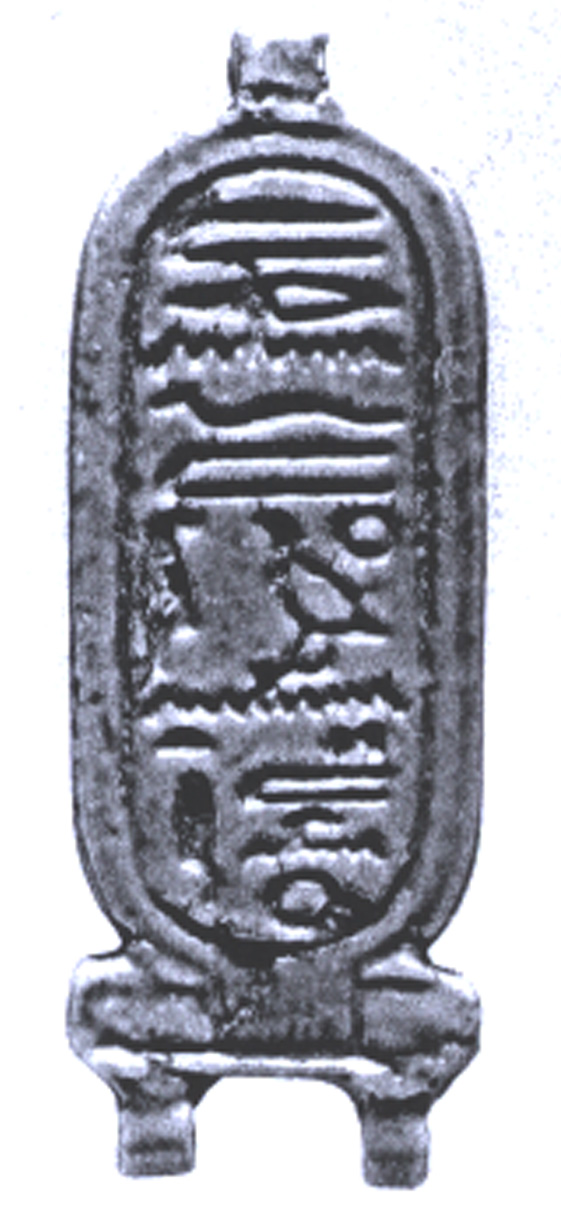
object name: jewelry plaque, aten cartouche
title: Aten cartouche for jewelry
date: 1353-1336 BCE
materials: faience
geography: egypt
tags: cartouches,hieroglyphs